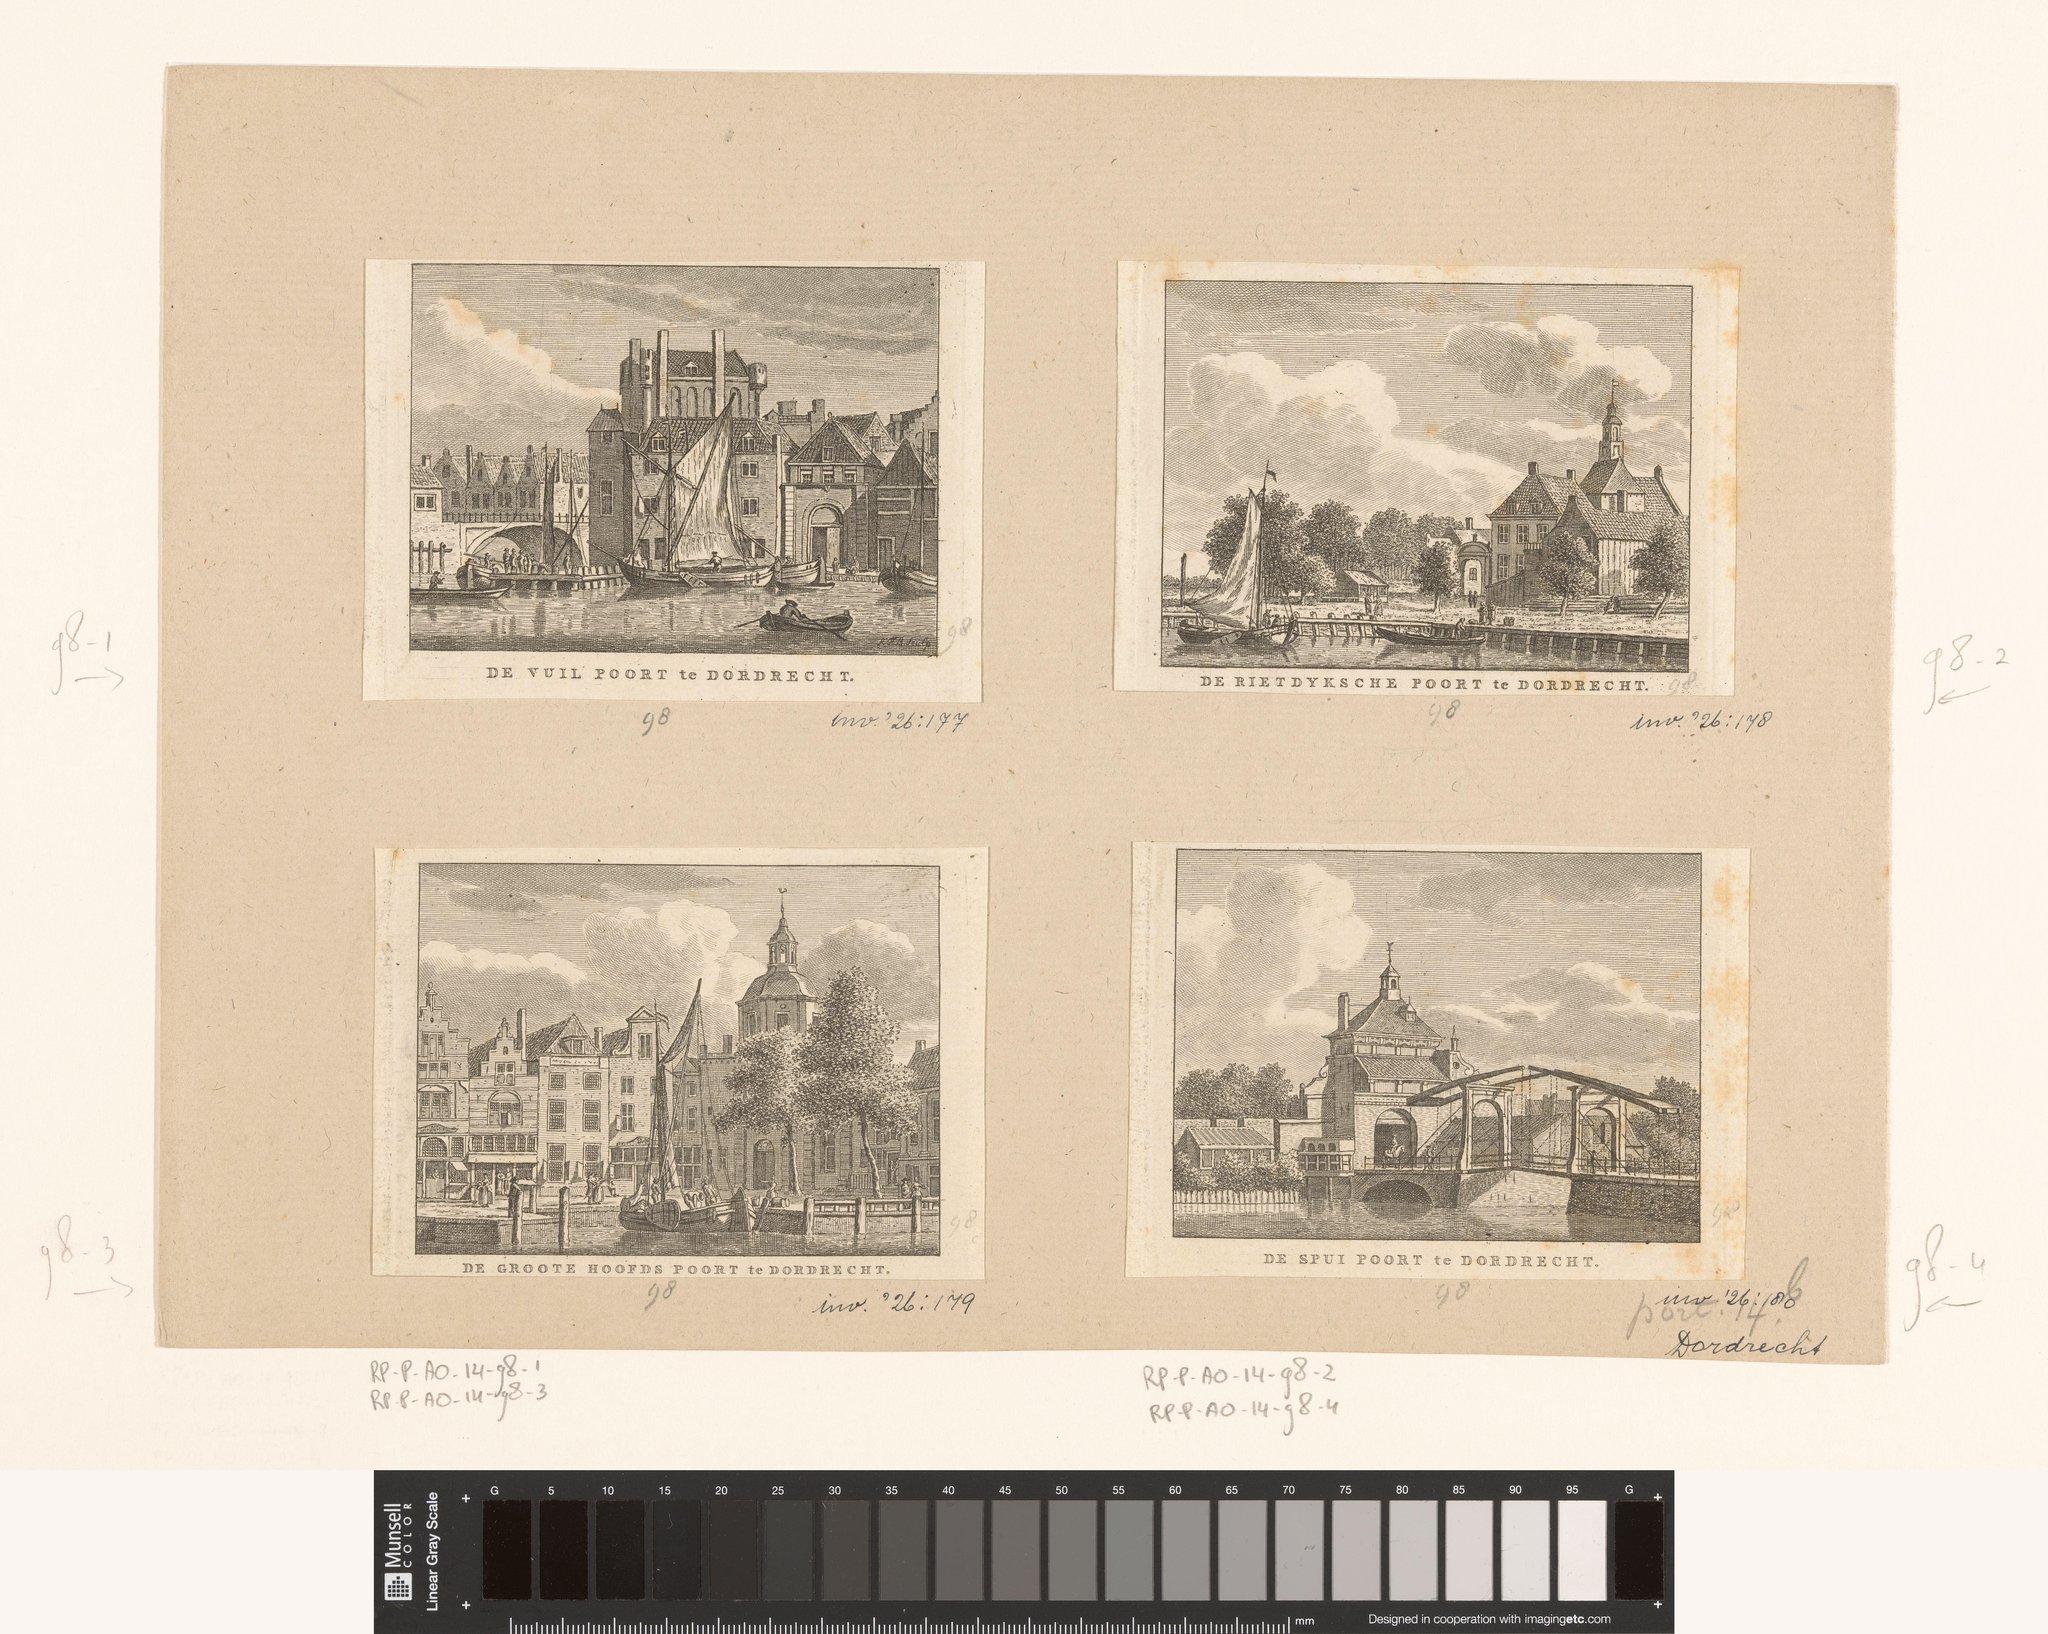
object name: print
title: Gezicht op de Nieuwe Vuilpoort te Dordrecht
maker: carel frederik bendorp (i)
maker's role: print maker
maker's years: 1736-1814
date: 1786-1792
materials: paper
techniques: engraving, etching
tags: sailing-ship, sailing-boat, rowing-boat, canoe, etc., bridge in city across river, canal, etc., city-gate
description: Prent uit: Vaderlandsche gezichten, of afbeeldingen van den tegenwoordigen staat der Vereenigde Nederlanden (…). Amsterdam: Hendrik Gartman, Willem Vermandel en Jan Willem Smit, 1786-1792. Uitgegeven in afleveringen met ieder een eigen bifolium en inhoudsopgave. Alle prenten in deze publicatie zijn gegraveerd door Carel Frederik Bendorp (I) en, in de meeste gevallen, gebaseerd op tekeningen van Jan Bulthuis.